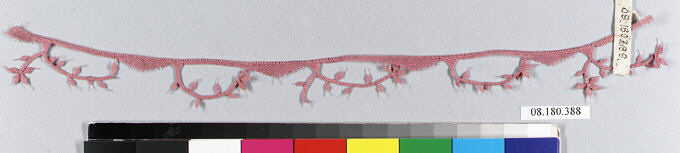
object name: fragment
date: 1801-1900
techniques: lace